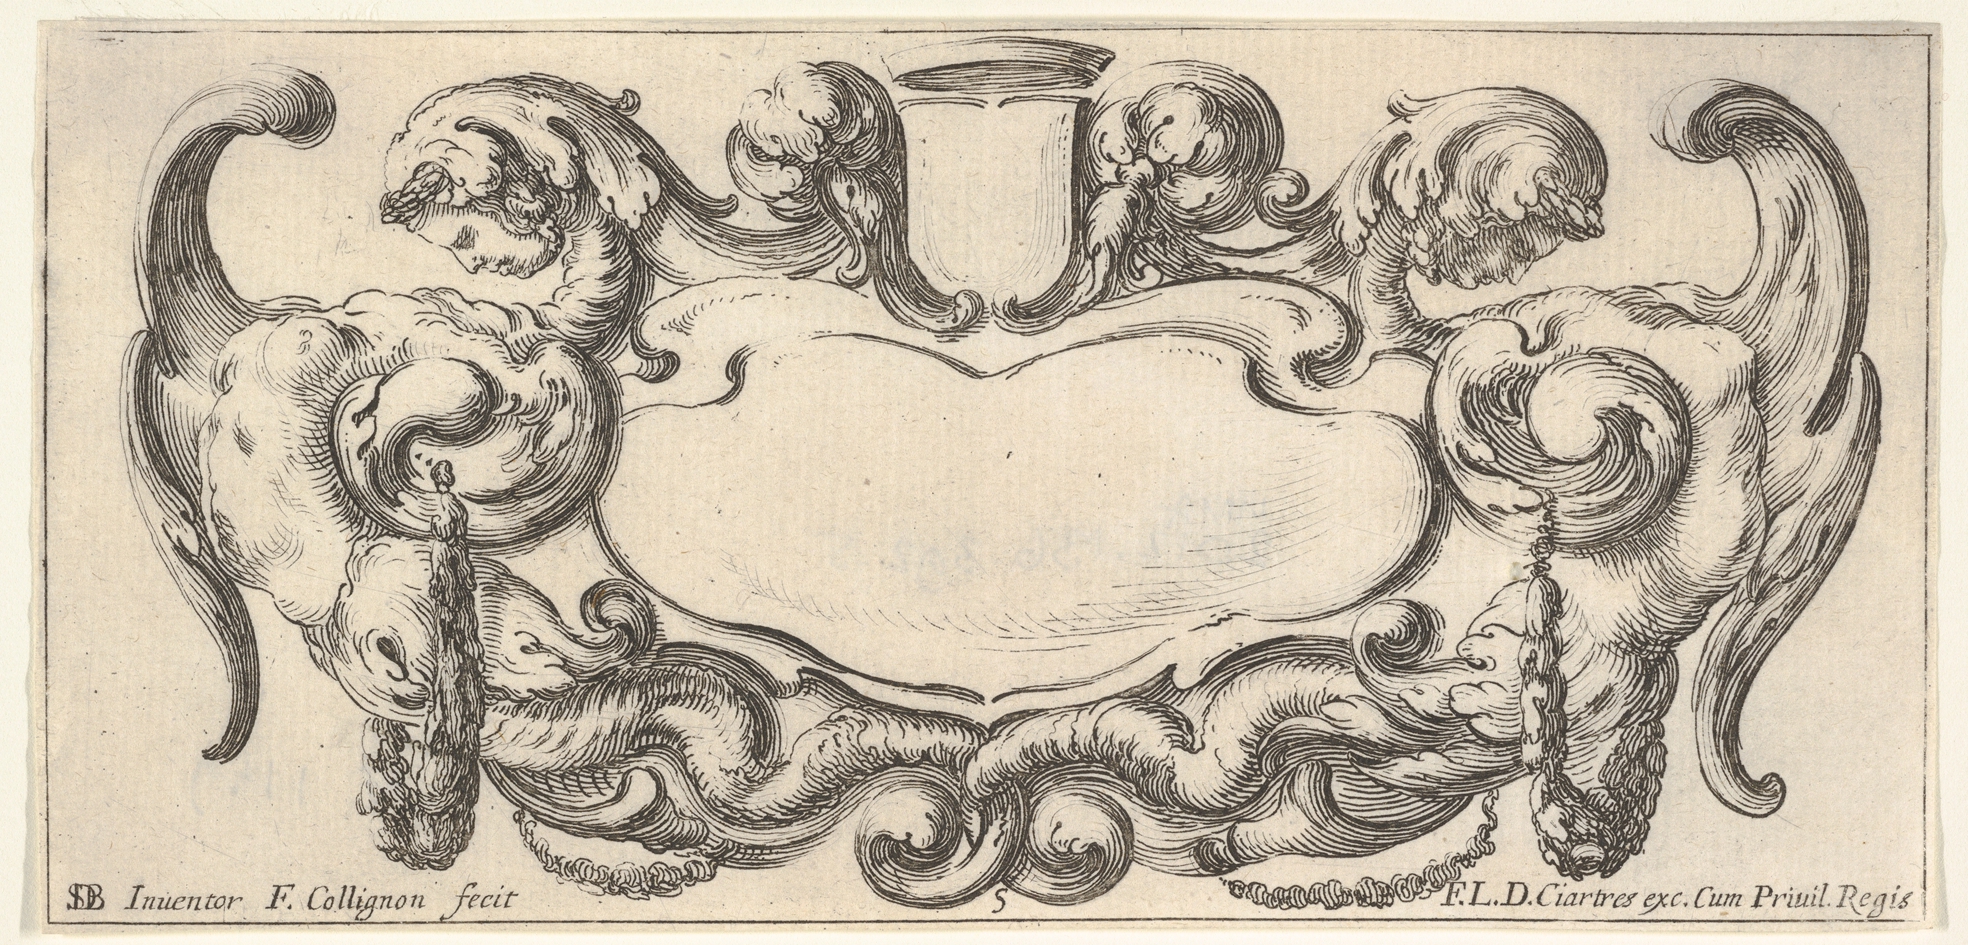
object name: print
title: Plate 5: a cartouche with a blank escutcheon at top center, a chimera to either side, their bodies ending in scrollwork and dragon tails, from "Twelve cartouches" (Recueil de douze cartouches)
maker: françois collignon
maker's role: artist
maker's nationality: french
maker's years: 1605-1687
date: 1640-1645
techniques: etching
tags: shields,cartouches